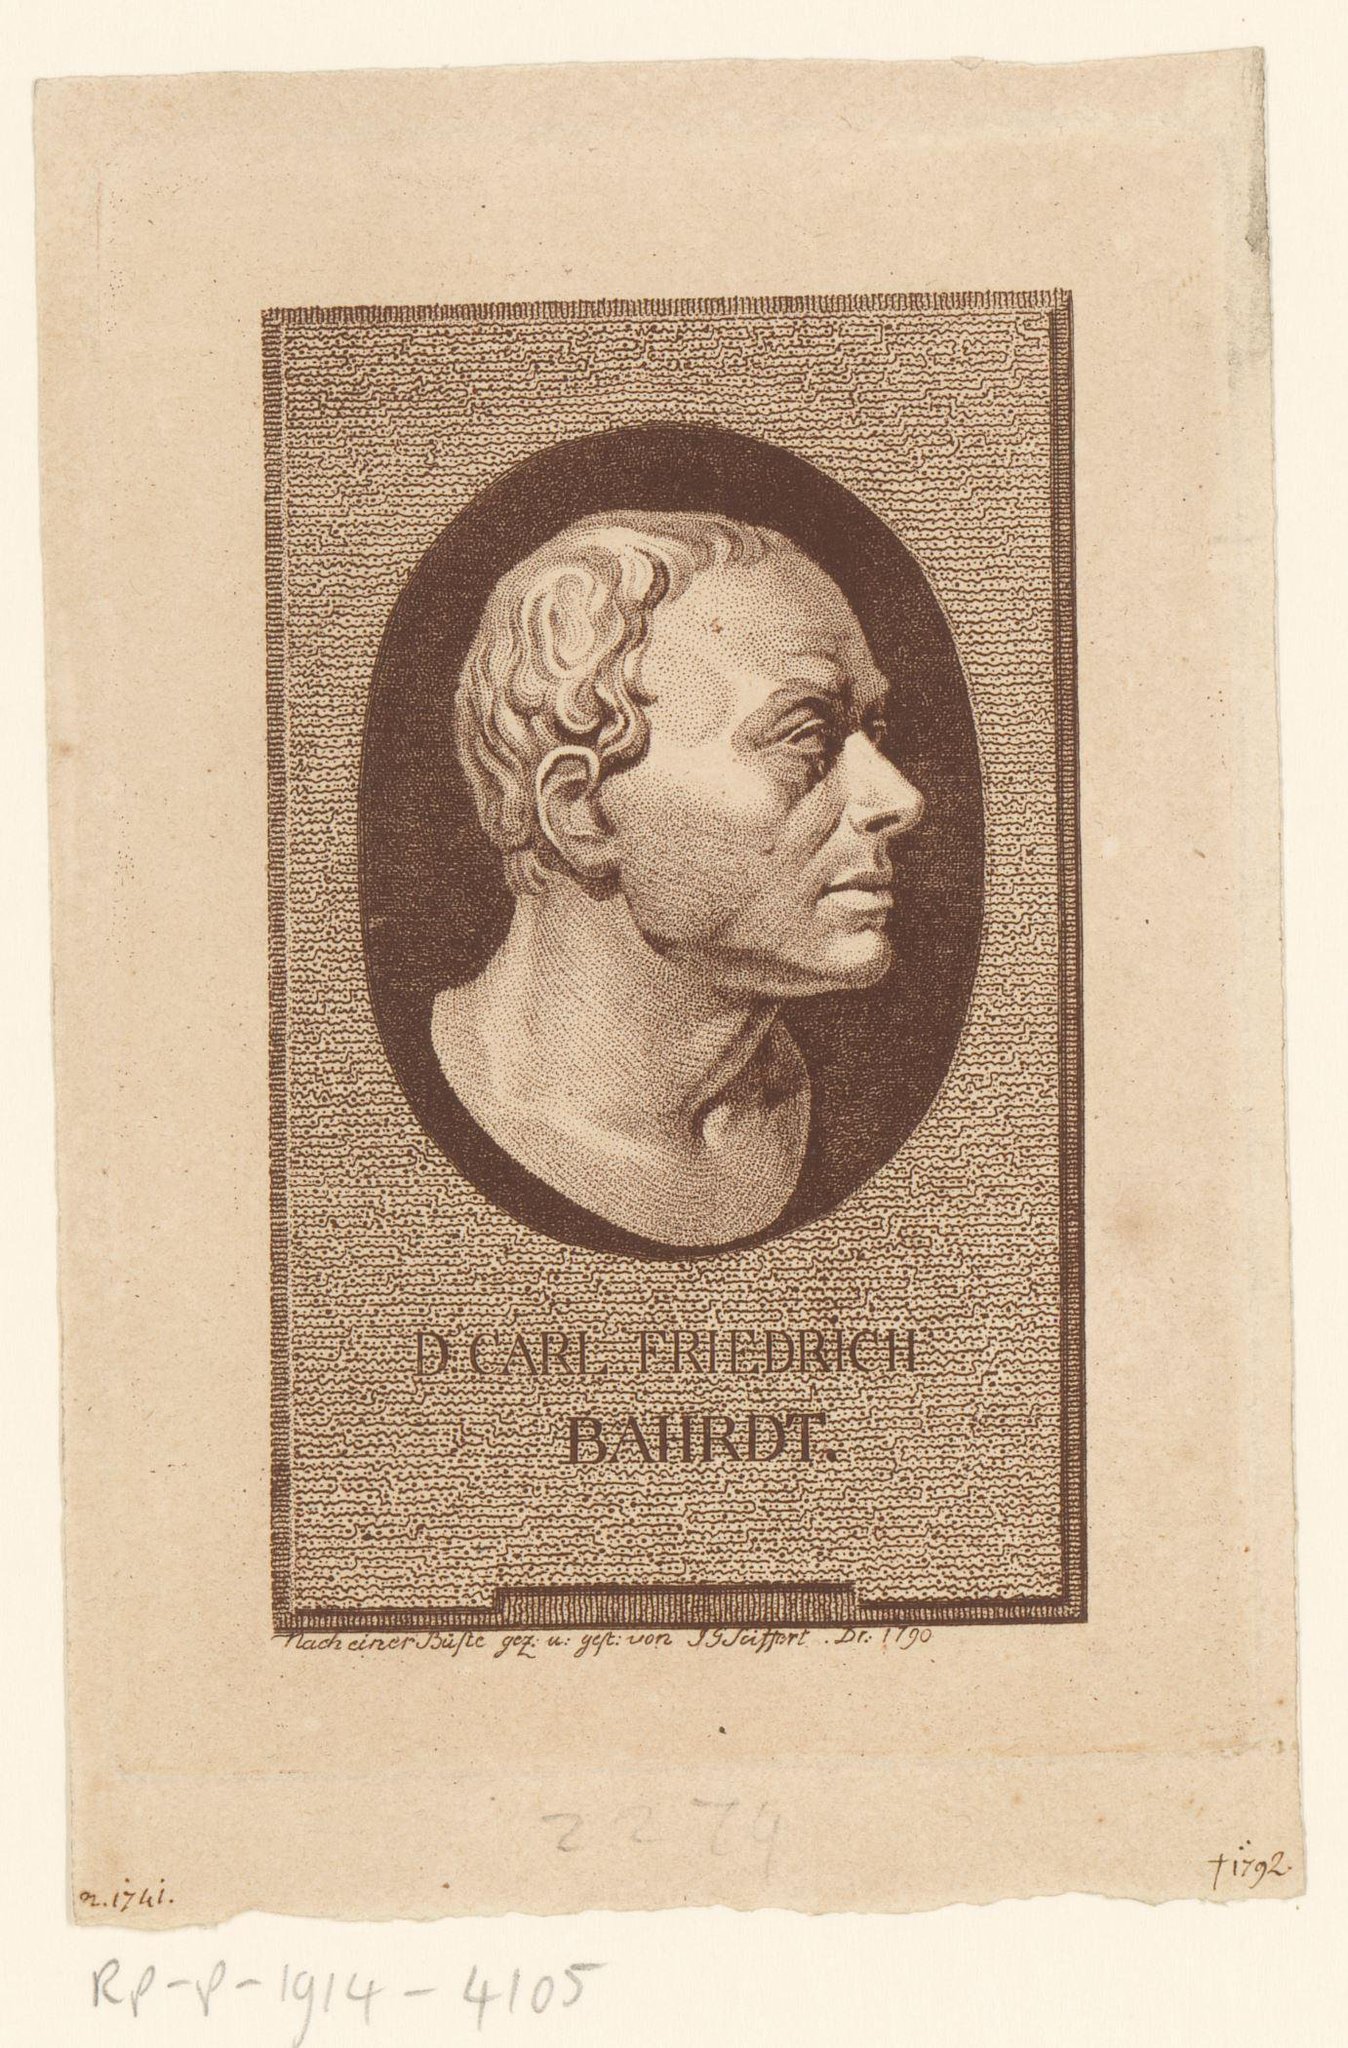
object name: print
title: Portret van Carl Friedrich Bahrdt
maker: johann gottlieb seyfert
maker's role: print maker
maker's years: 1761-1824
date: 1790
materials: paper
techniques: engraving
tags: historical persons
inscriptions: collector's mark: Lugt 2228